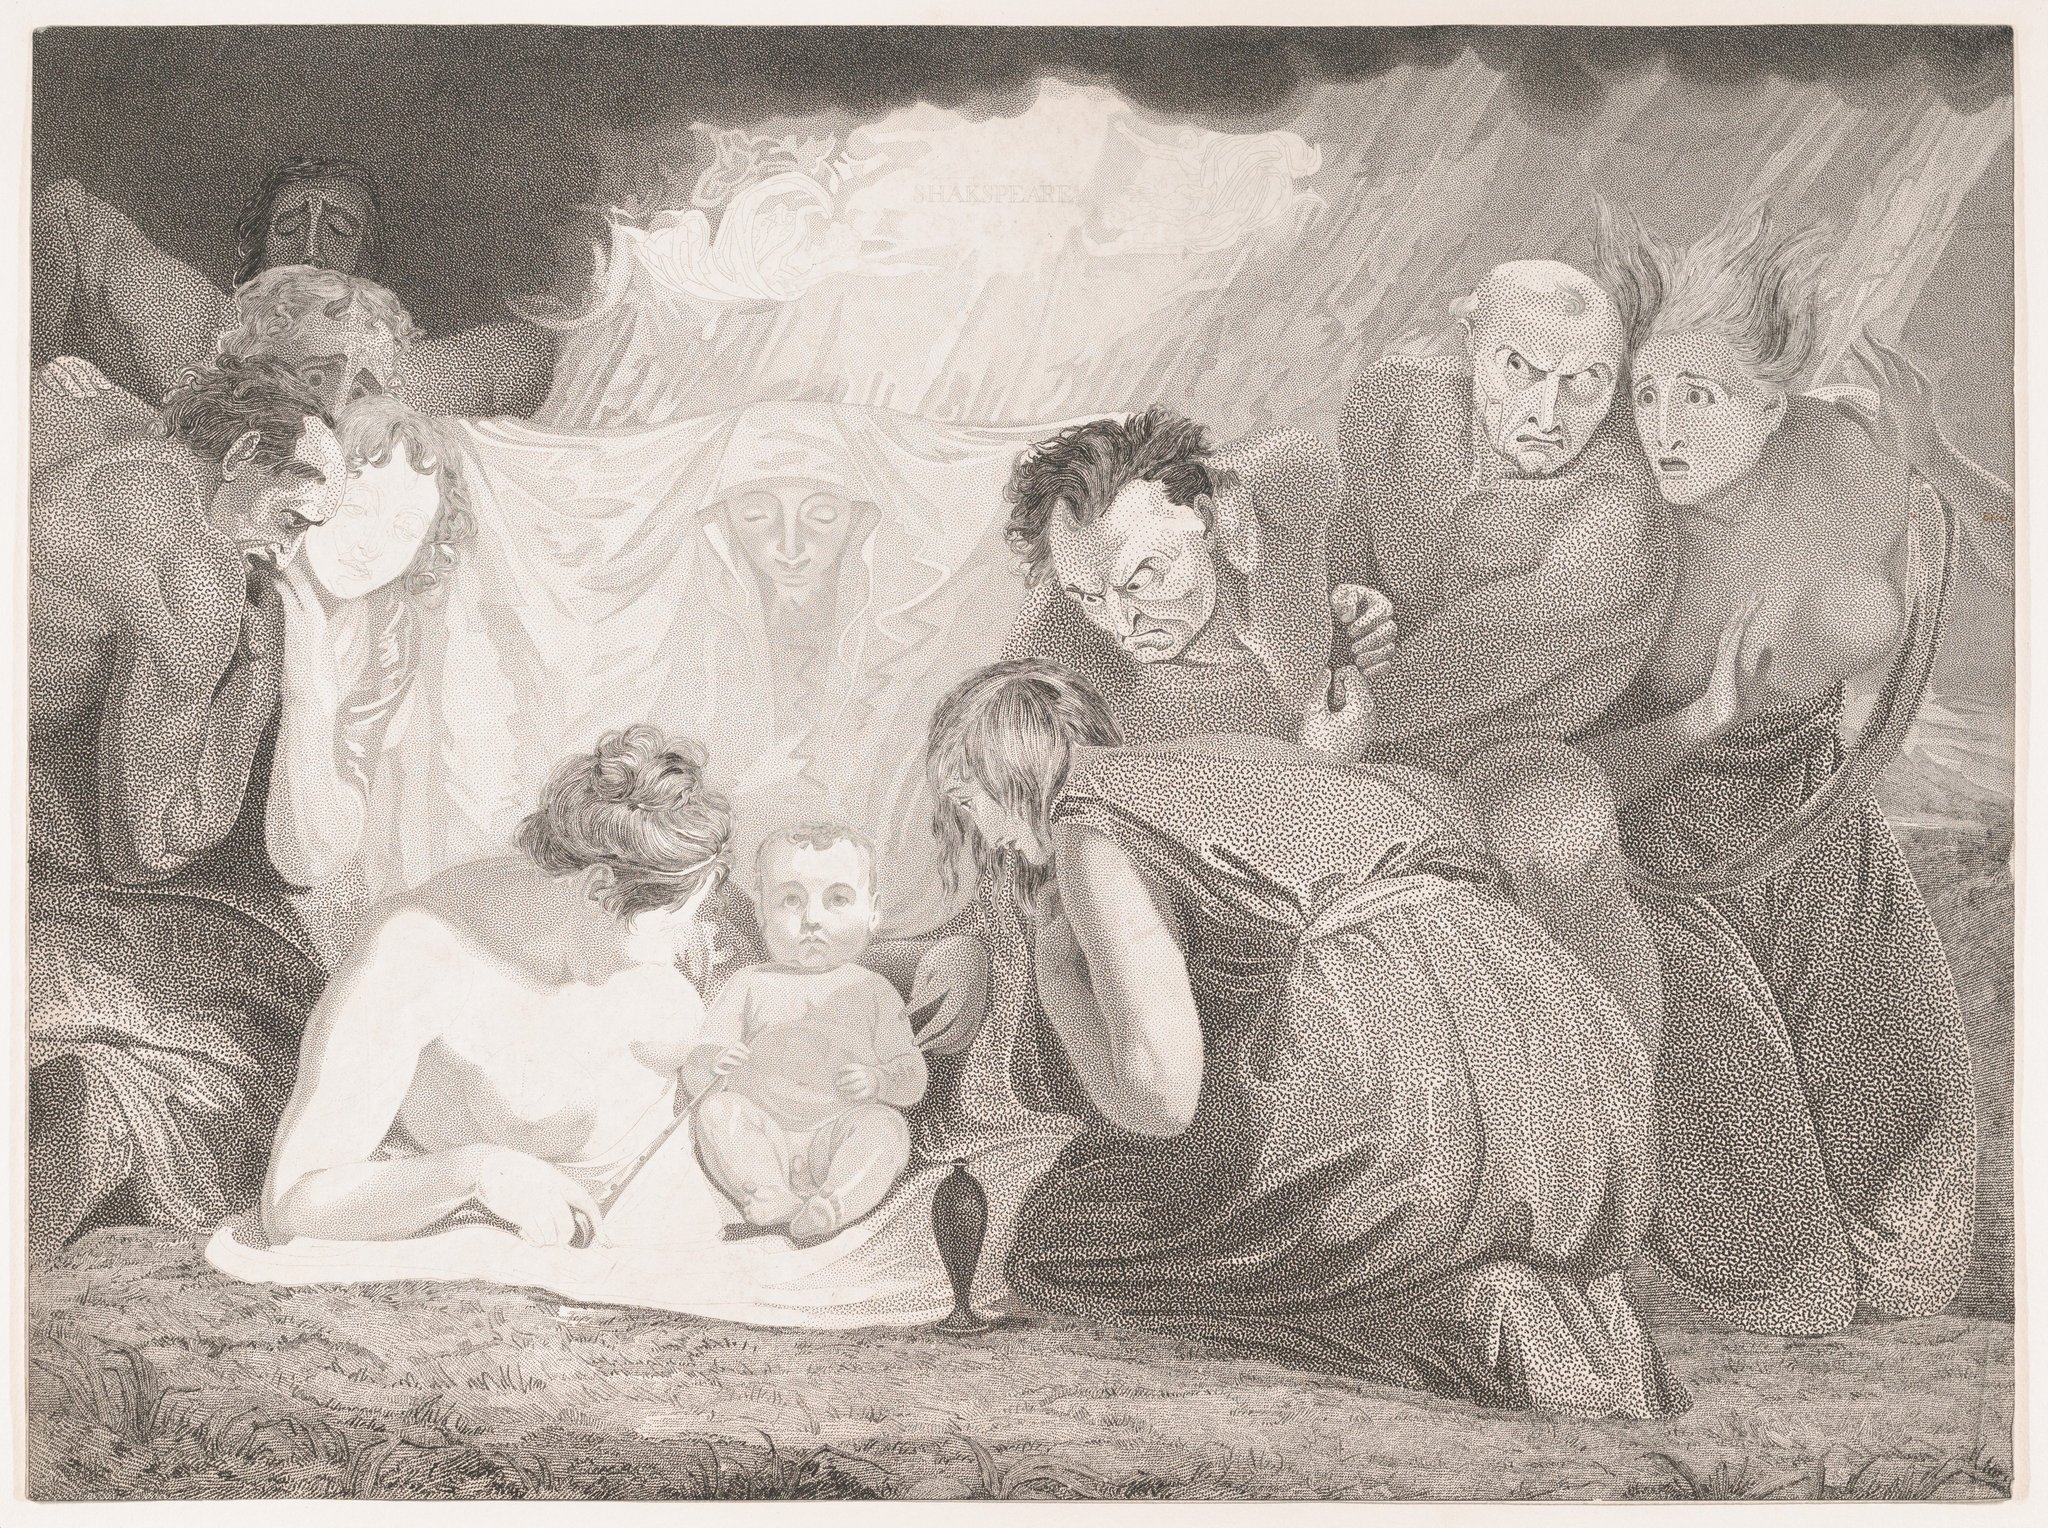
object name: print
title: Infant Shakespeare Attended by Nature and the Passions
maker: benjamin smith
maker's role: engraver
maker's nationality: british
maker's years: 1775-1833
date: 1799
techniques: engraving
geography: england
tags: shakespeare,infants,men,female nudes